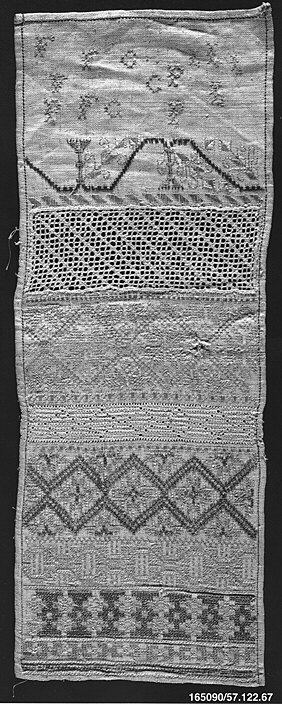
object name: sampler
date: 1801-1900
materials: linen, silk